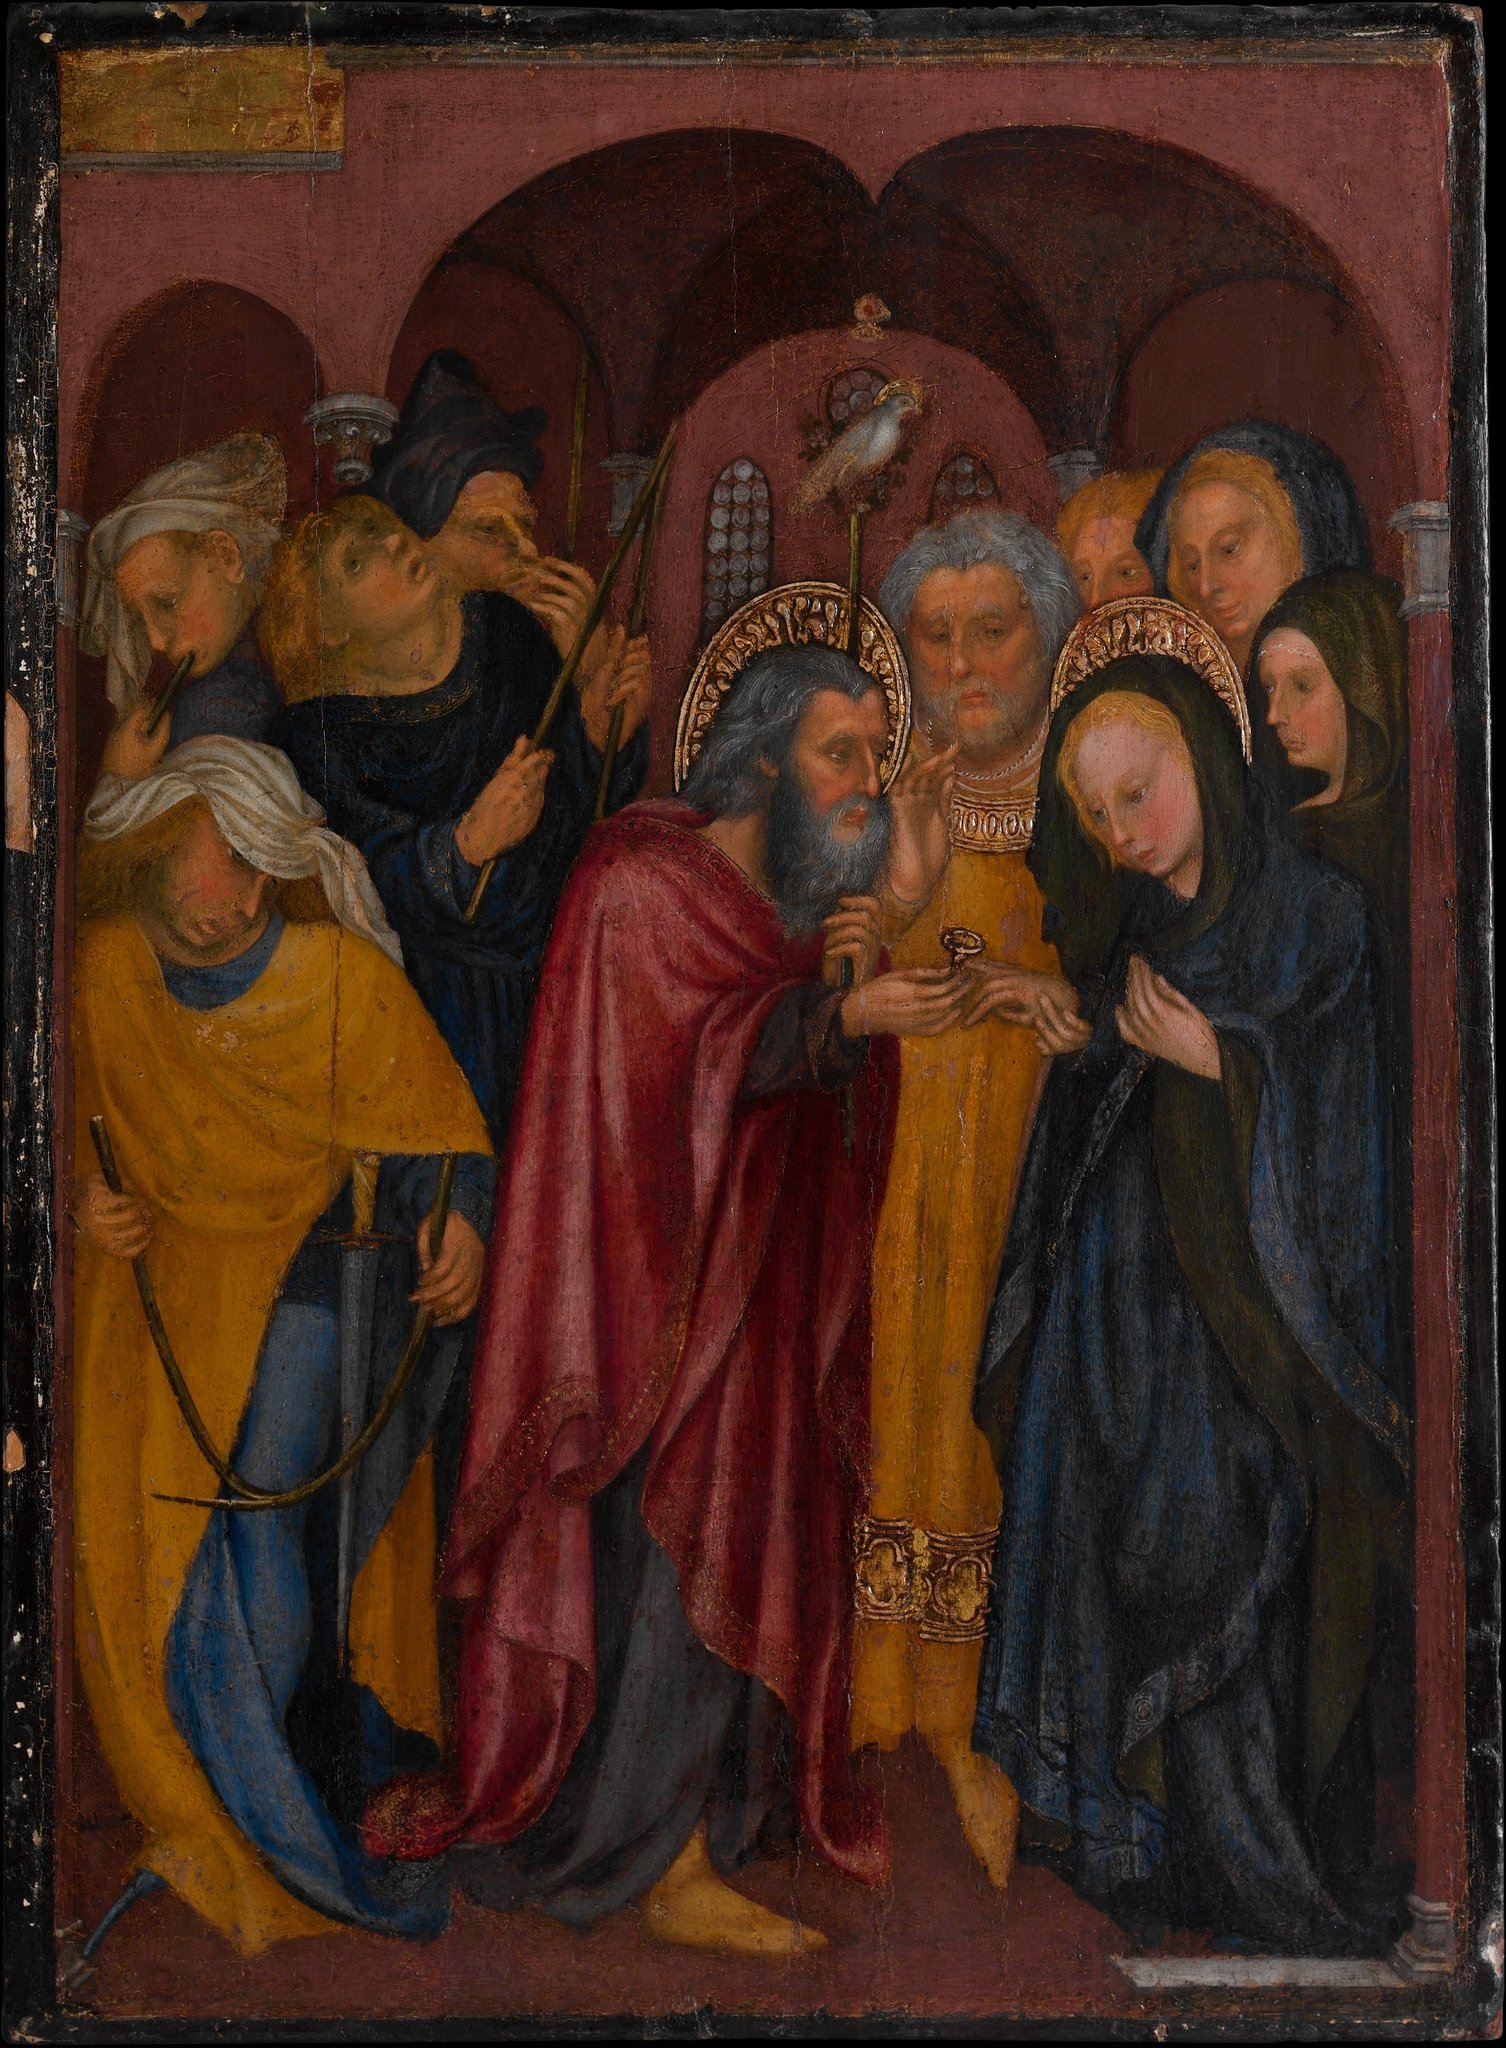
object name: painting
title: The Marriage of the Virgin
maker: michelino da besozzo (michelino de mulinari)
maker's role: artist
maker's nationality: italian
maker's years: 1388-1450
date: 1430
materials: gold, paint, wood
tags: birds,men,virgin mary,saints,joseph,marriage of the virgin